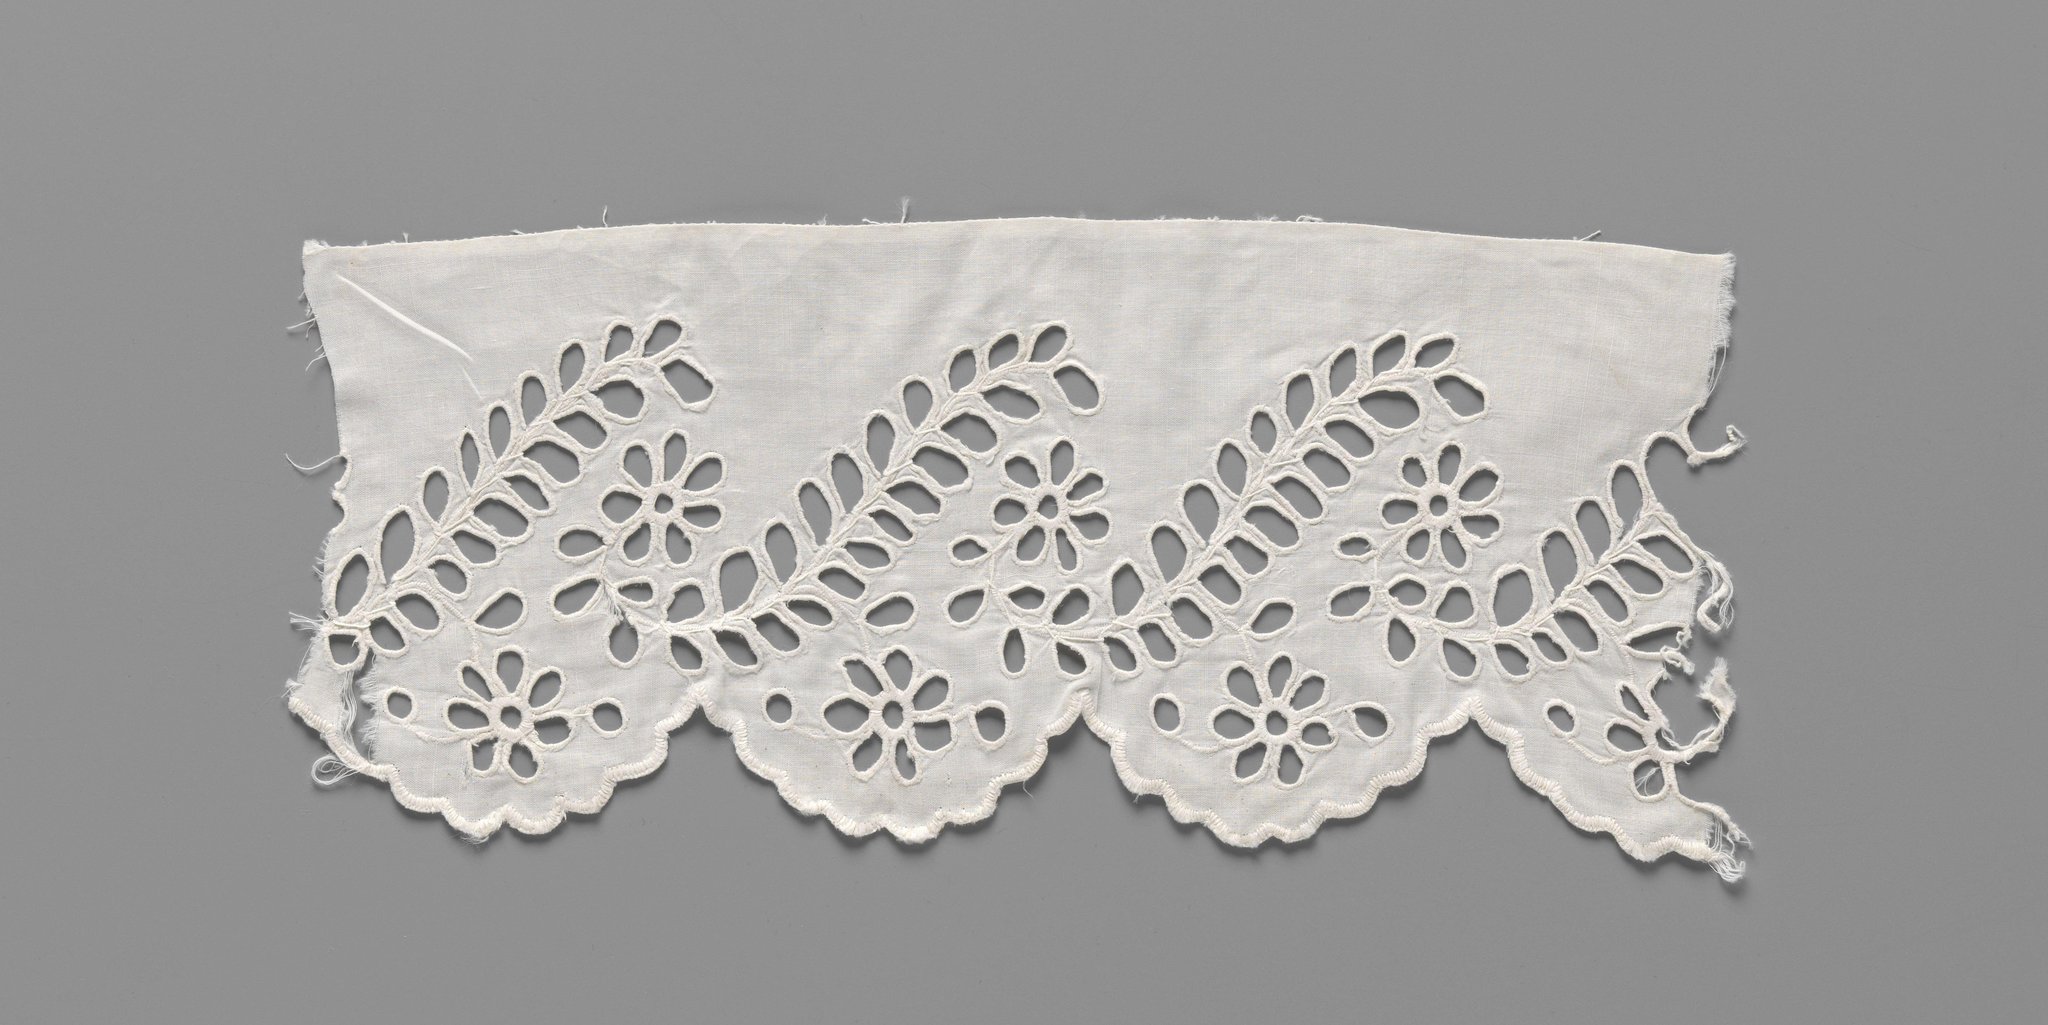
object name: strip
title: Strook katoen met kantborduurwerk met margrieten tussen gevederde s-vormige bladeren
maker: c.i. bosch reitz-teding van berkhout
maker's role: kantwerkster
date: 1860-1880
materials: cotton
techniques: weave, embroidery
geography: amsterdam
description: Strook naturelkleurig katoen met kantborduurwerk: Engels borduurwerk. Het patroon heeft schuine, gevederde S-bladeren tussen twee margrieten, waarvan een in elke schulp hangt.